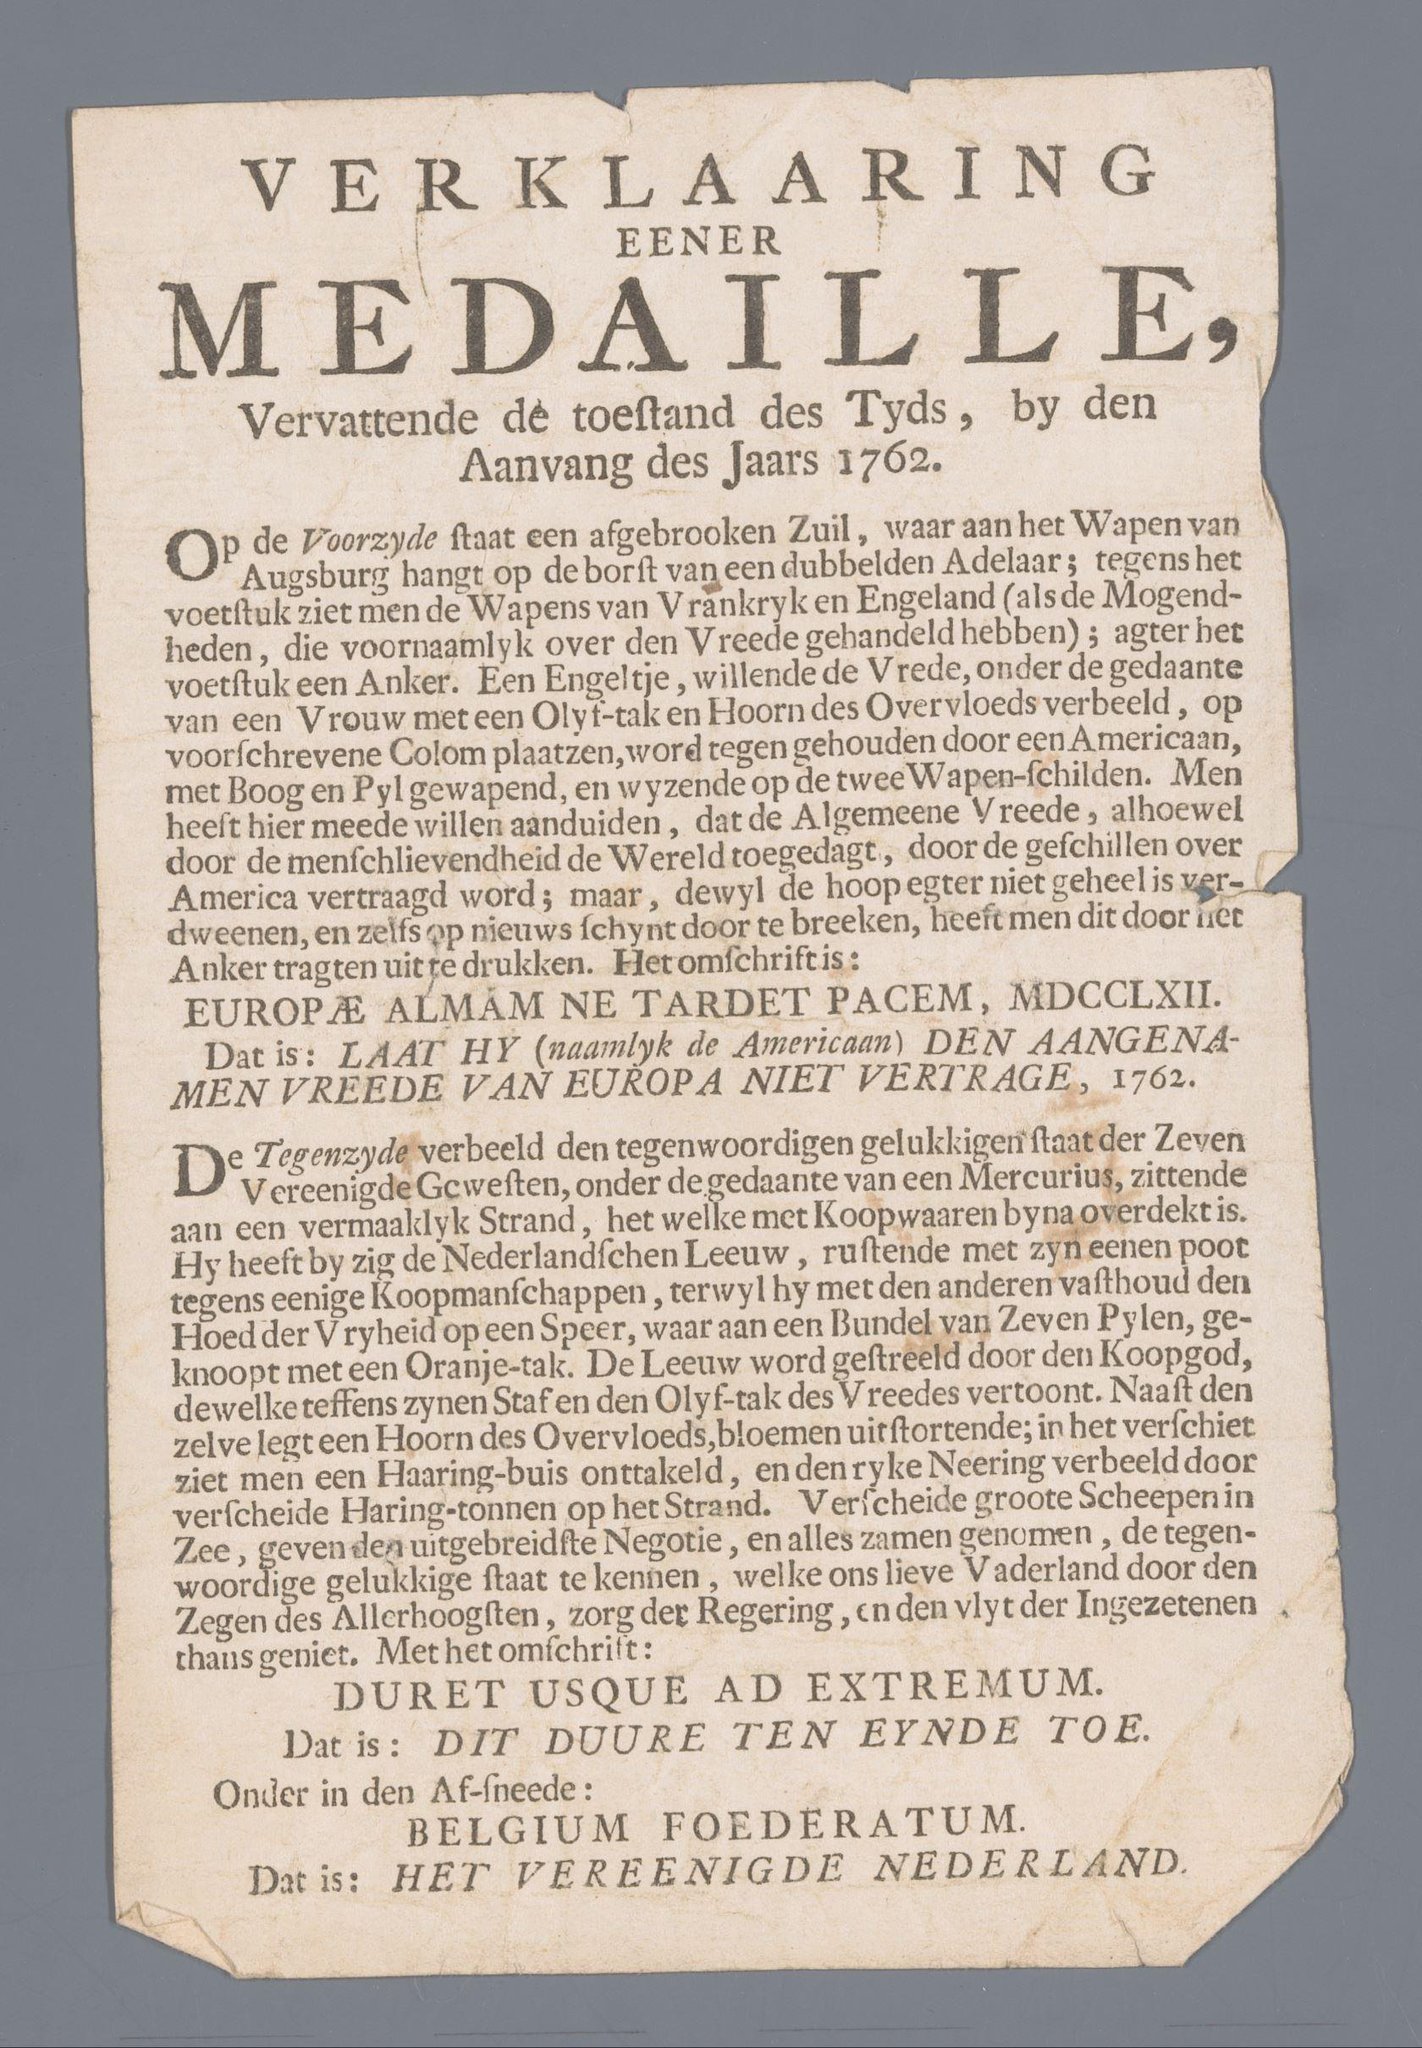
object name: pamphlet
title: Verklaring van de penning door Johan George Holtzhey geslagen op de aanvang van het jaar 1762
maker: Anonymous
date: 1762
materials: paper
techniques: printing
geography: amsterdam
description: Eenzijdig, rechthoekig papier met opschrift, gedrukt in zwarte inkt; op de keerzijde opschrift "65 / niet / 1 v G.", waarvan het cijfer in bruine, en de beide onderste woorden in zwarte inkt geschreven.